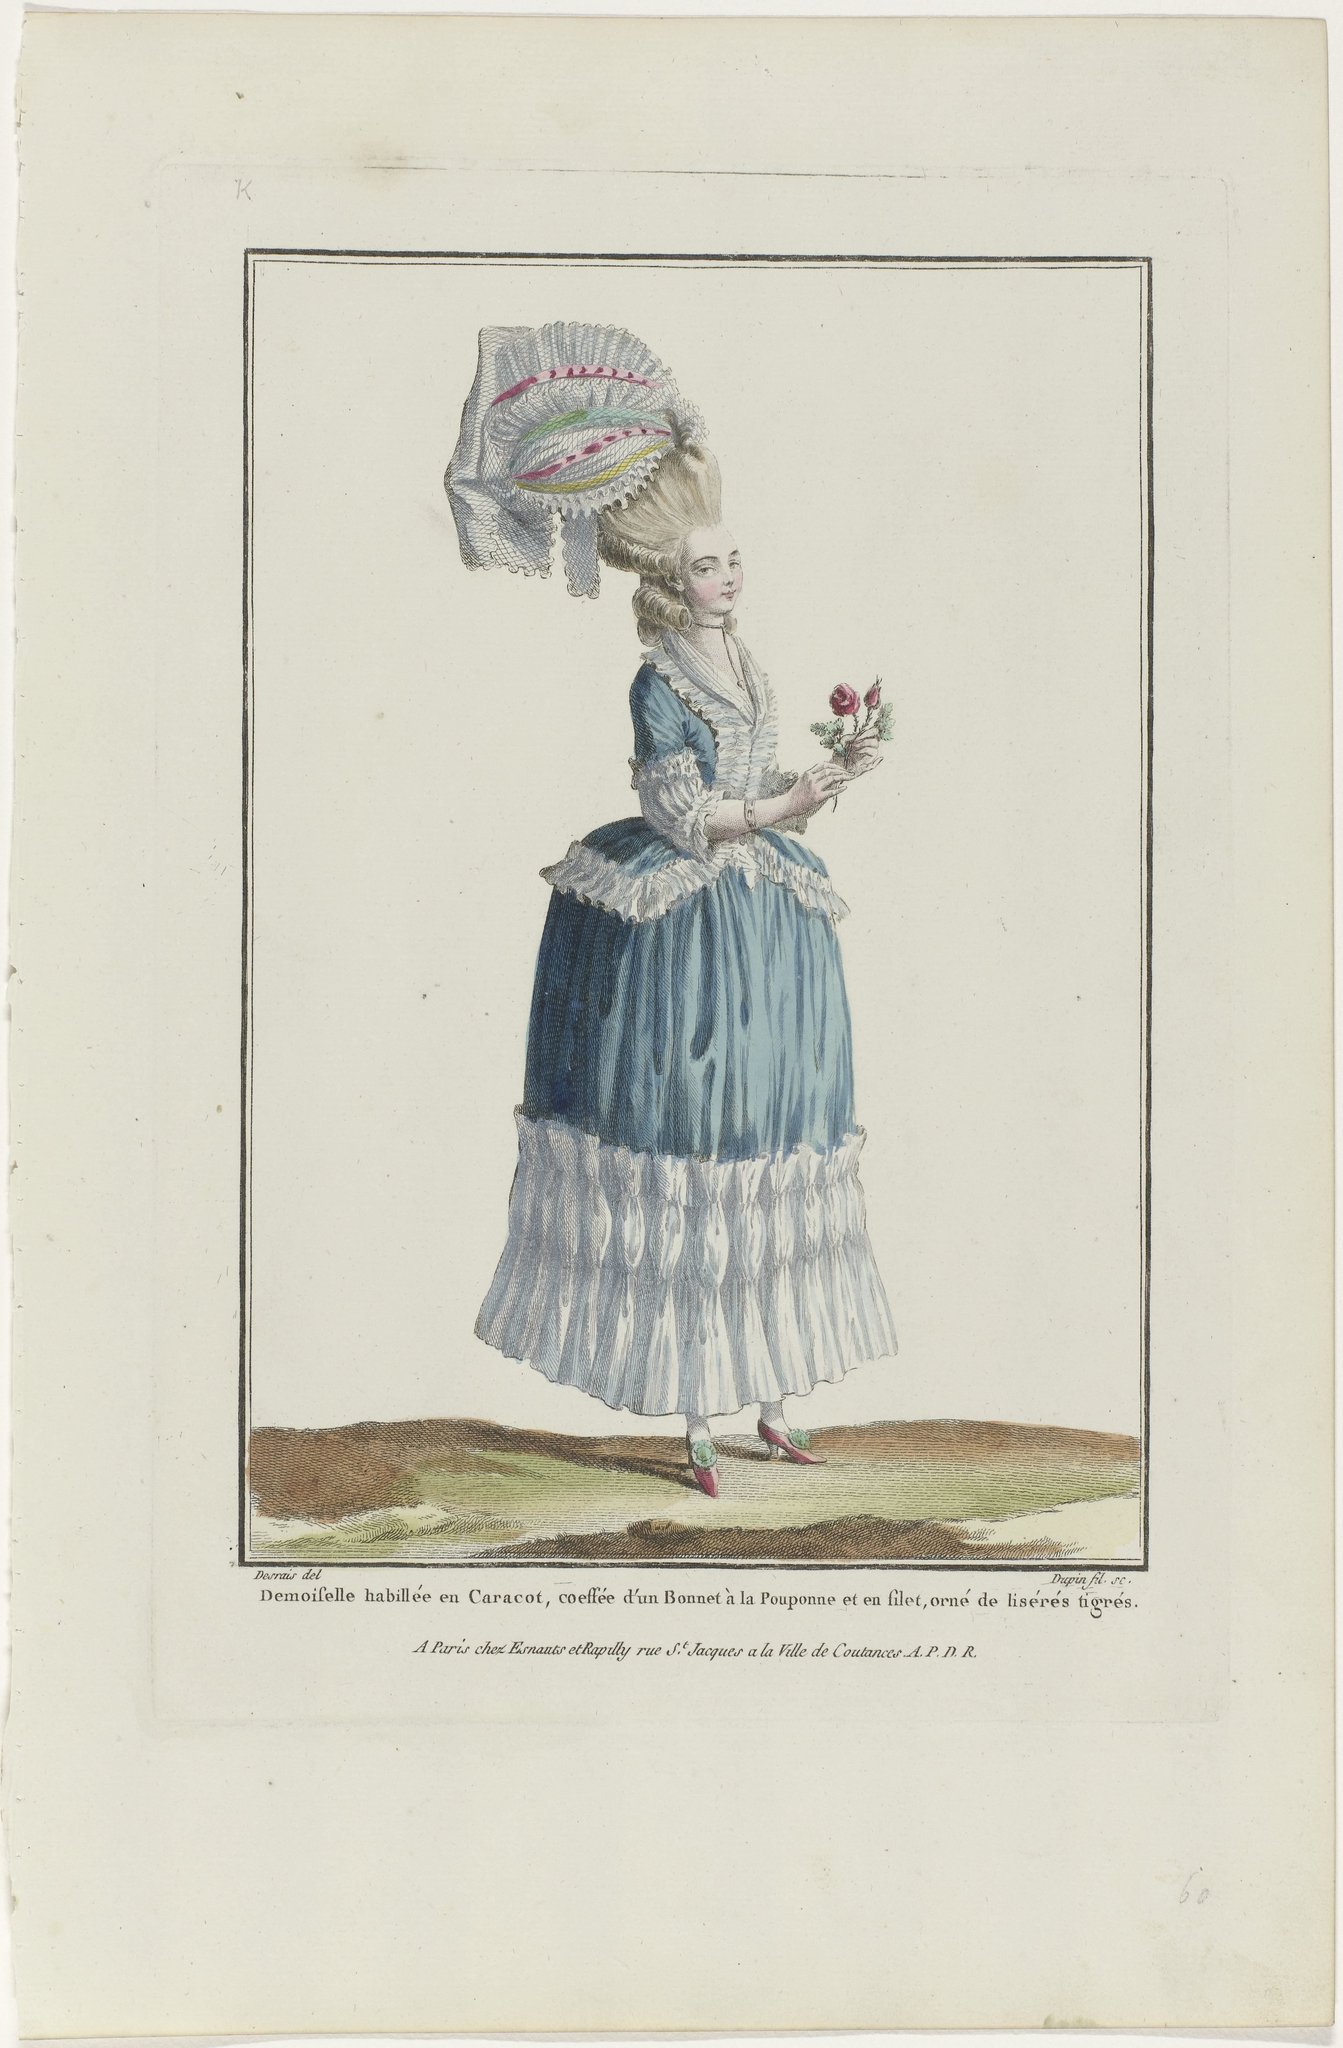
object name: fashion print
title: Gallerie des Modes et Costumes Français, 1778, K 59 : Demoiselle habillée en Caracot (...)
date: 1778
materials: paper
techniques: engraving, hand coloring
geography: paris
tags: clothing for the upper part of the body (caraco) (+ women's clothes), head-gear: cap (+ women's clothes), head-gear (bonnet) (+ women's clothes), fashion plates, skirt (+ women's clothes), piece of clothing covering the breast or décolleté (+ women's clothes), flowers: rose, bracelet, wristlet (+ women's clothes), necklace (+ women's clothes)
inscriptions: address: ‘A Paris chez Esnauts et Rapilly rue St. Jacques a la Ville de Coutances. A.P.D.R.’, caption: ‘Demoiselle habillée en Caracot, coeffée d'un Bonnet à la Pouponne et en filet, orné de lisérés tigrés.’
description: Jonge ongetrouwde vrouw in caraco op een rok met falbala. Om de hals een fichu. Op het hoge kapsel een 'Bonnet à la Pouponne', ofwel een muts van filet versierd met gestippeld boordsel. Accessoires: geknoopt koord om de hals, armband, schoenen met hakken en rozetten. Prent uit serie K. 10e Cahier des Costumes Français, 4e Suite d'Habillemens à la mode, Gallerie des Modes et Costumes Français.